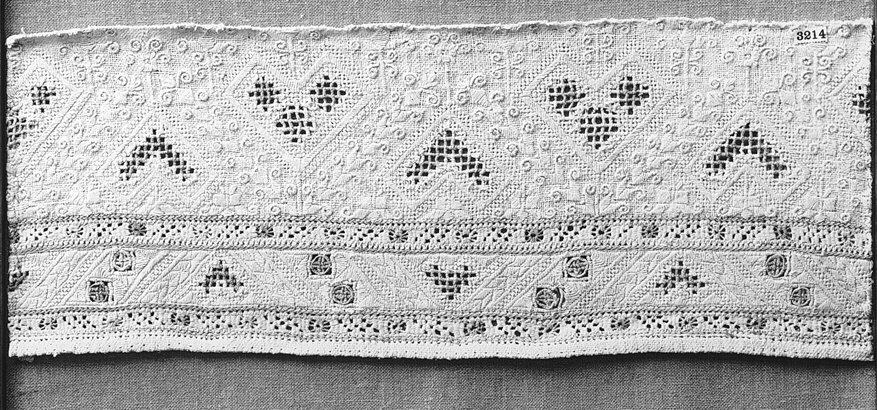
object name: fragment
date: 1601-1700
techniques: embroidery